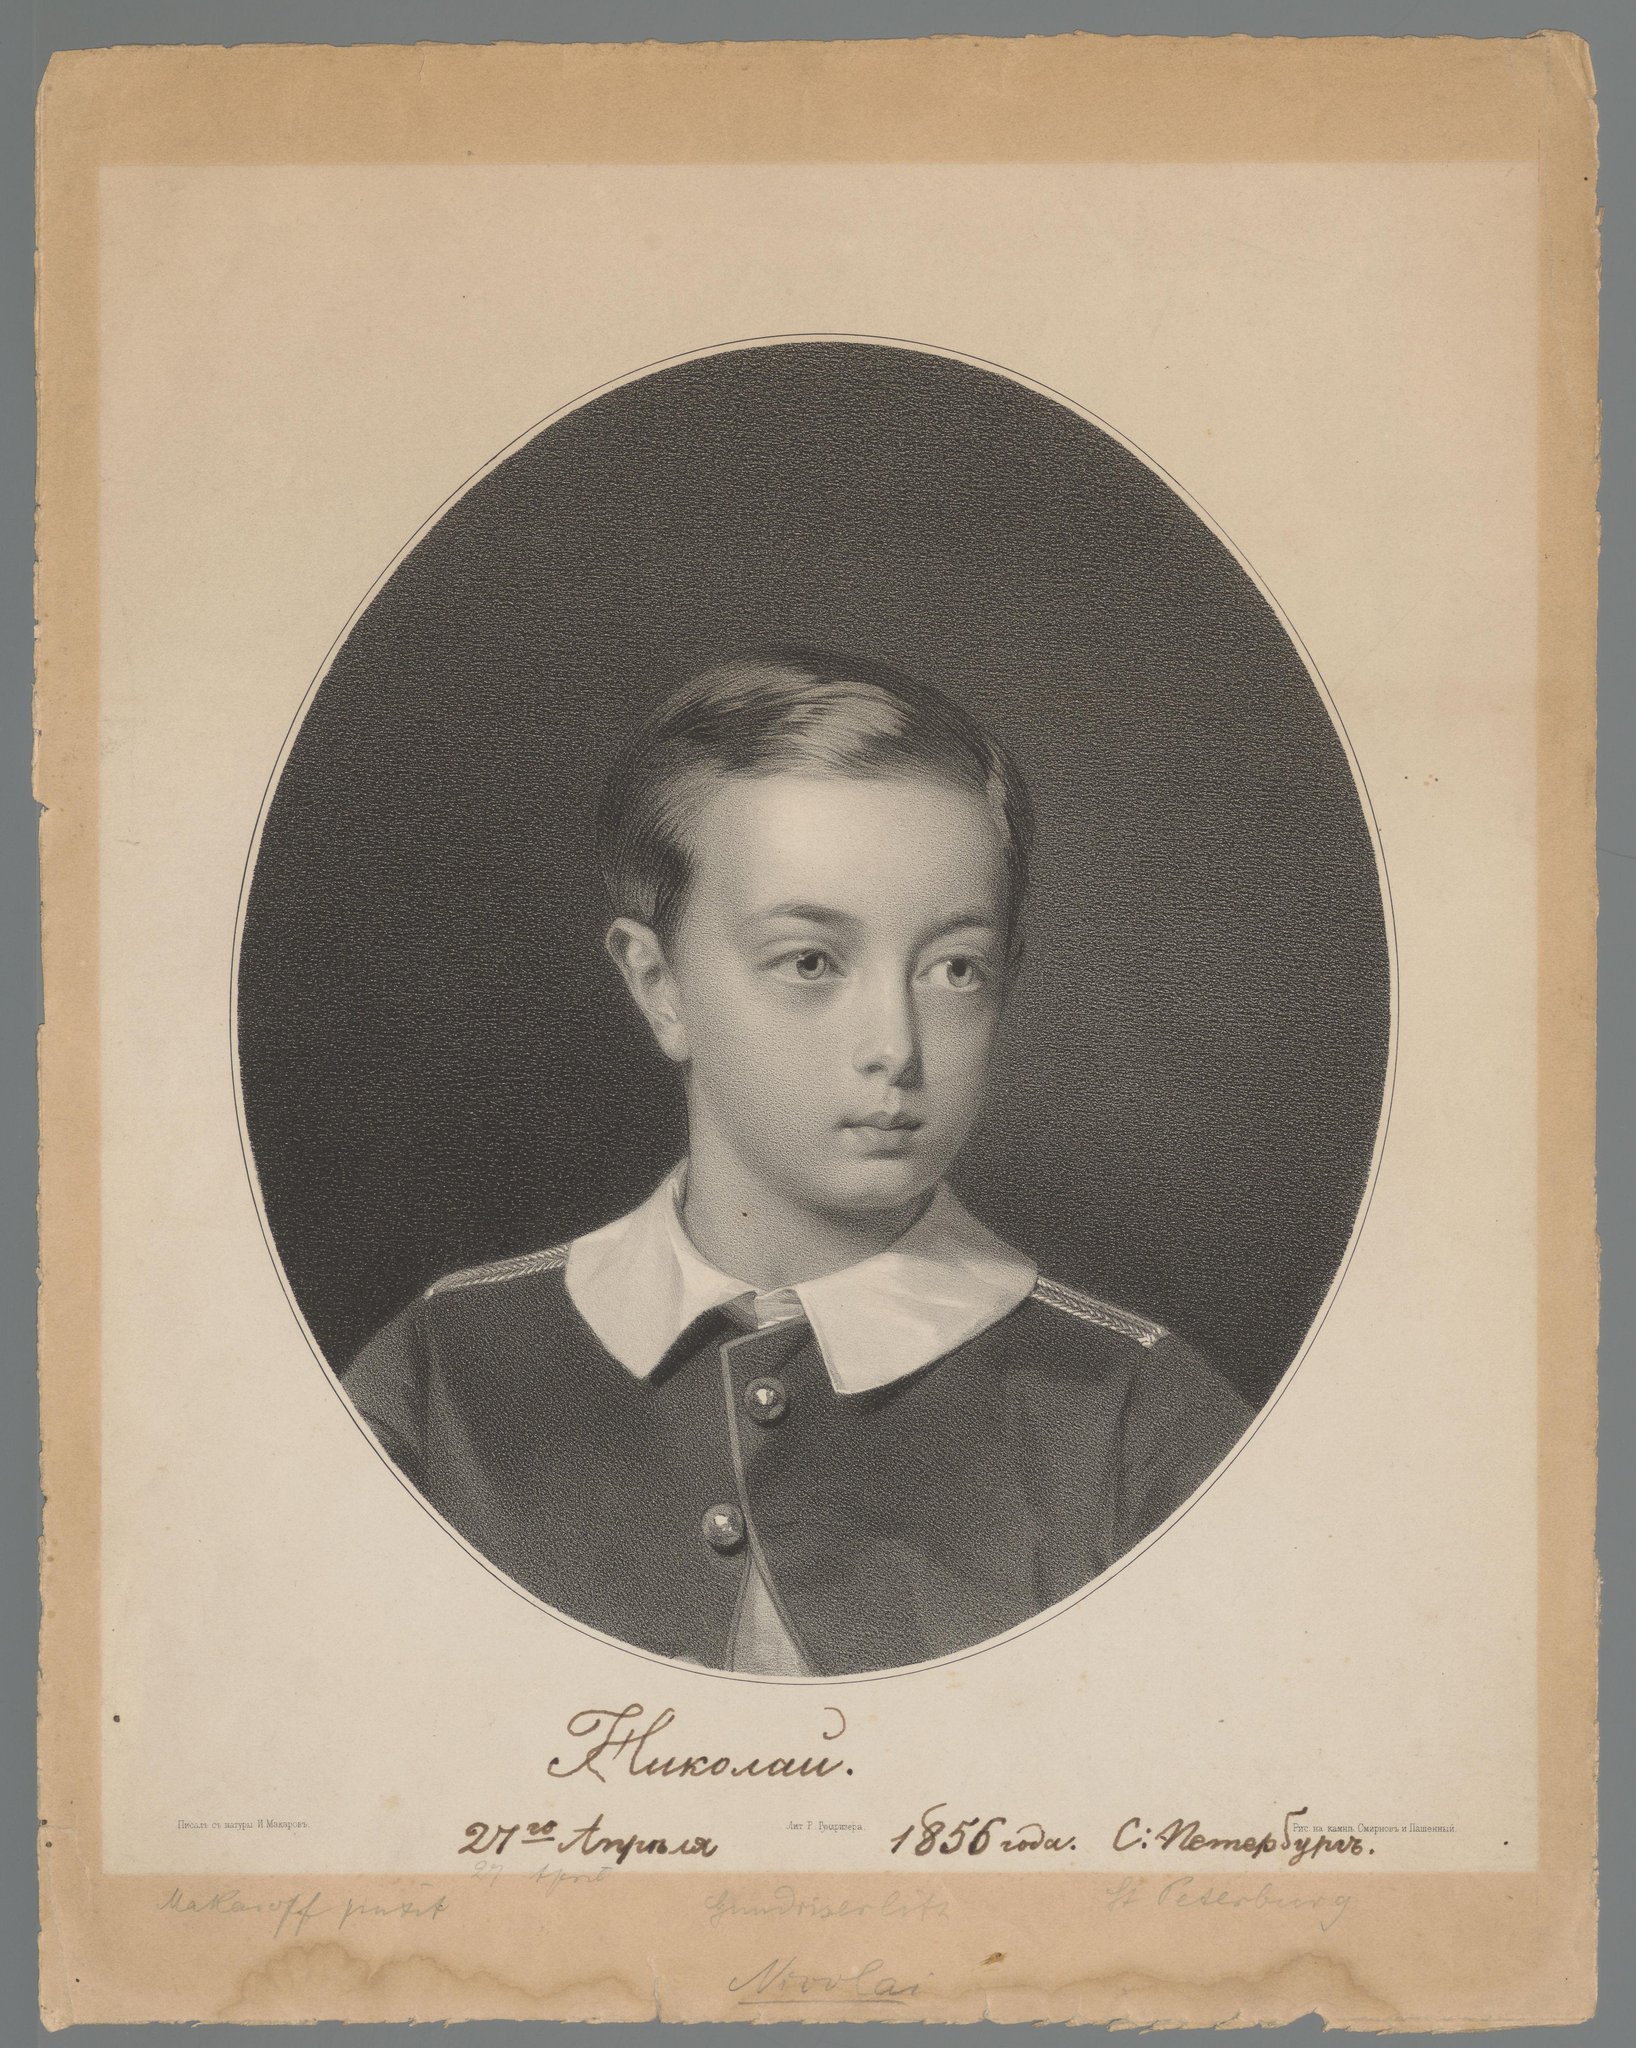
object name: print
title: Portret van Nicolaas Aleksandrovitsj van Rusland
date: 1856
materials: paper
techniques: lithograph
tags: historical persons, youth, adolescent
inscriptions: inscription, collector's mark: Lugt 2233